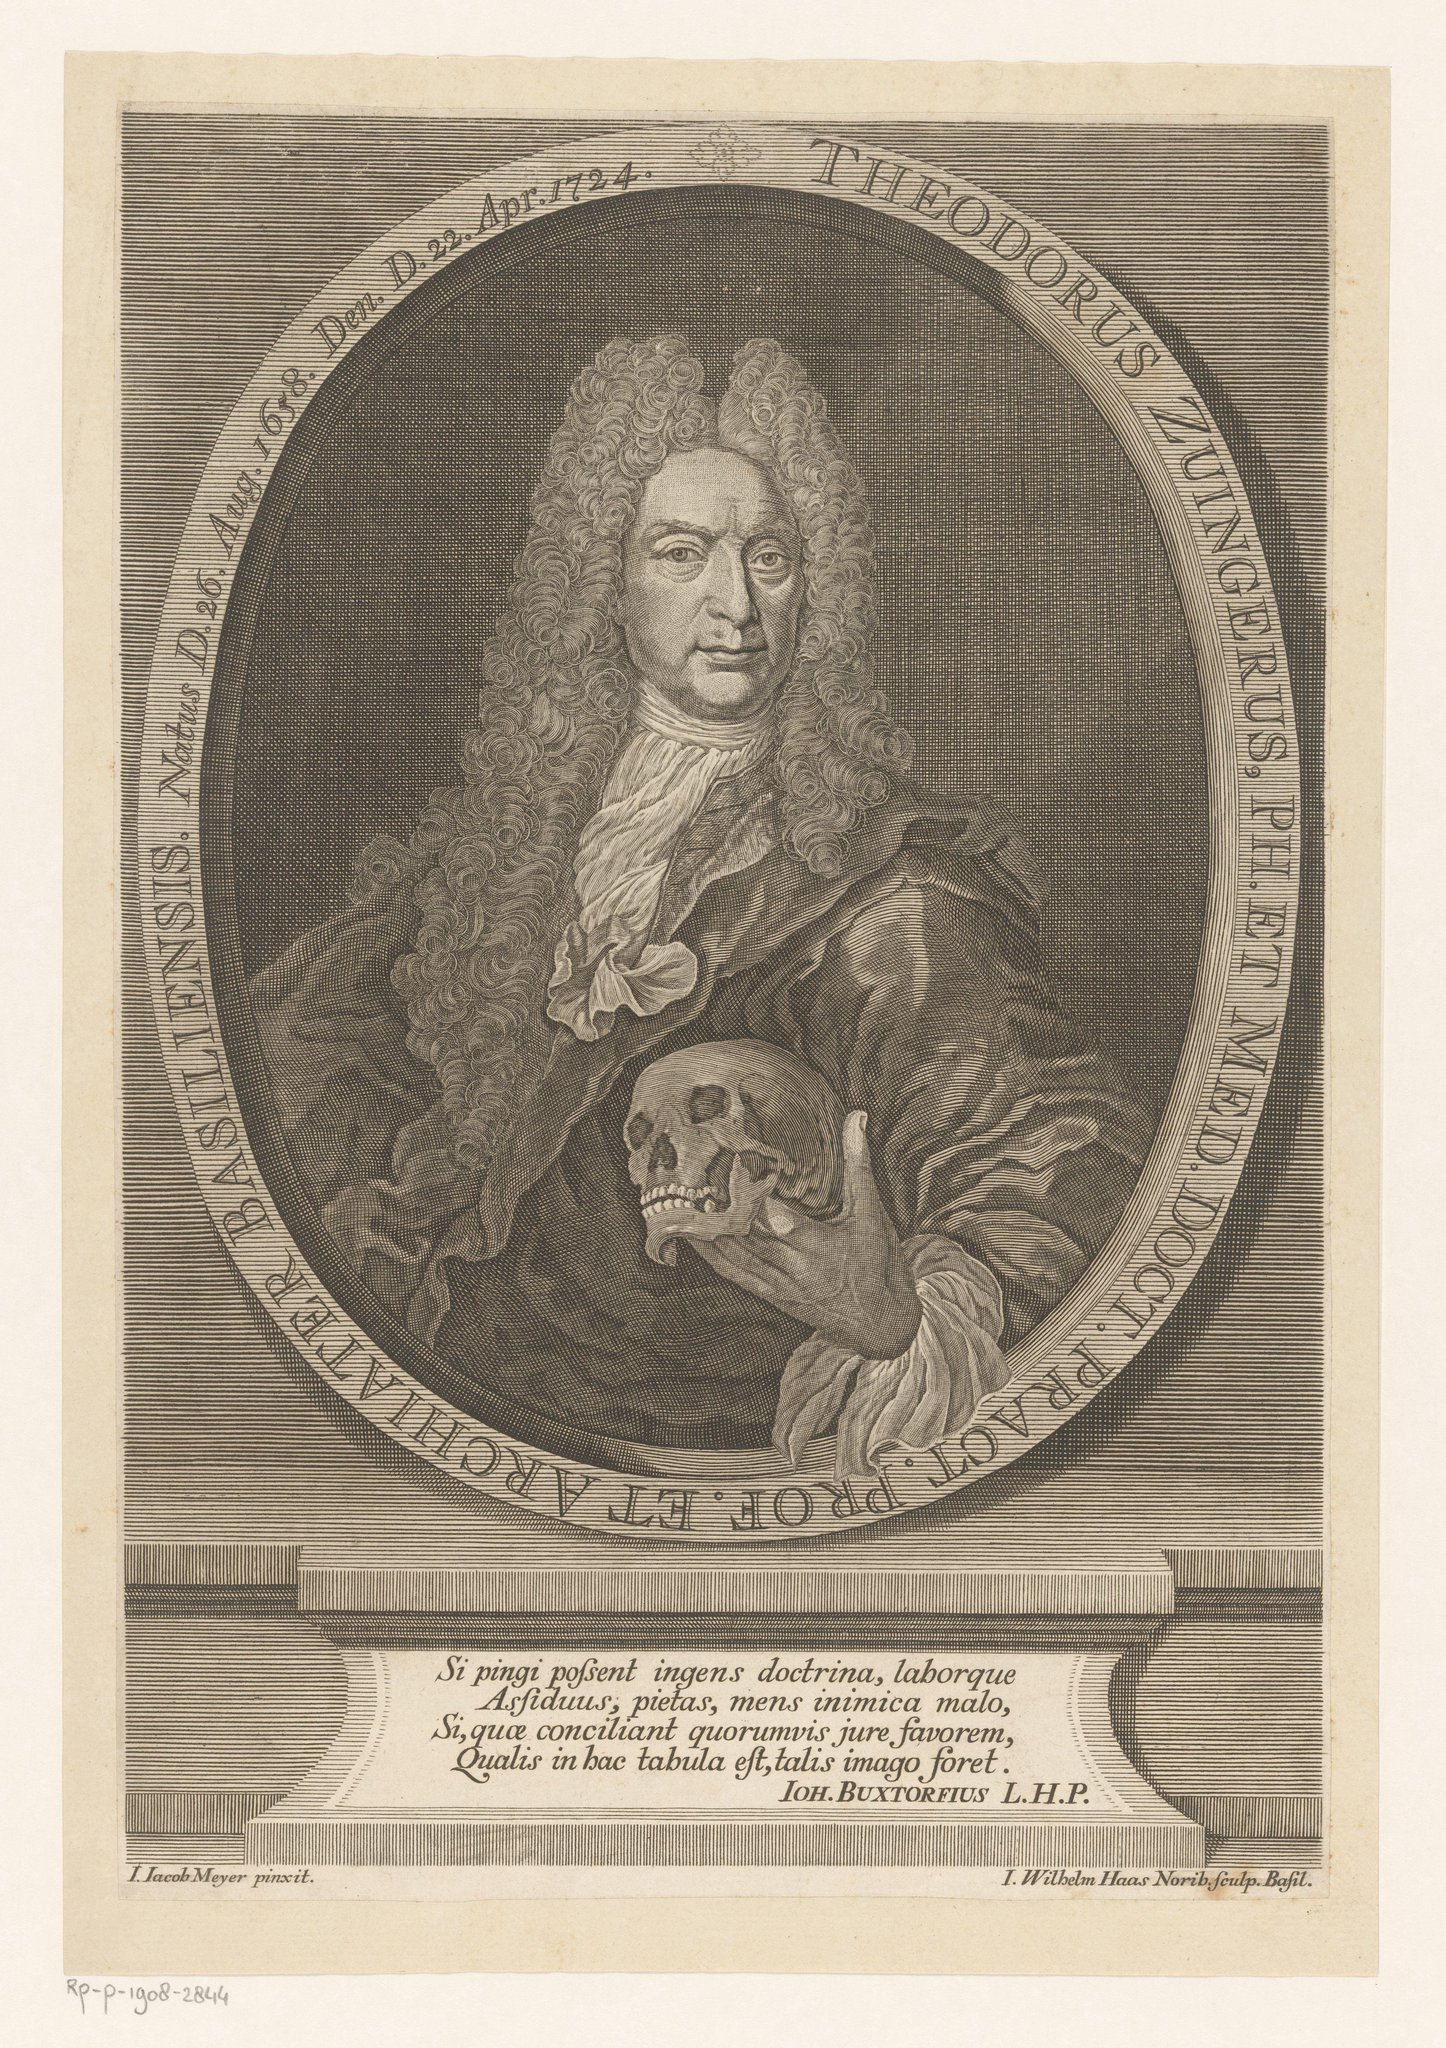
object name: print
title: Portret van Theodor Zwinger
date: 1751-1800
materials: paper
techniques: engraving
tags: historical persons, skull as symbol of 'vanitas'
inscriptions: collector's mark: Lugt 2228